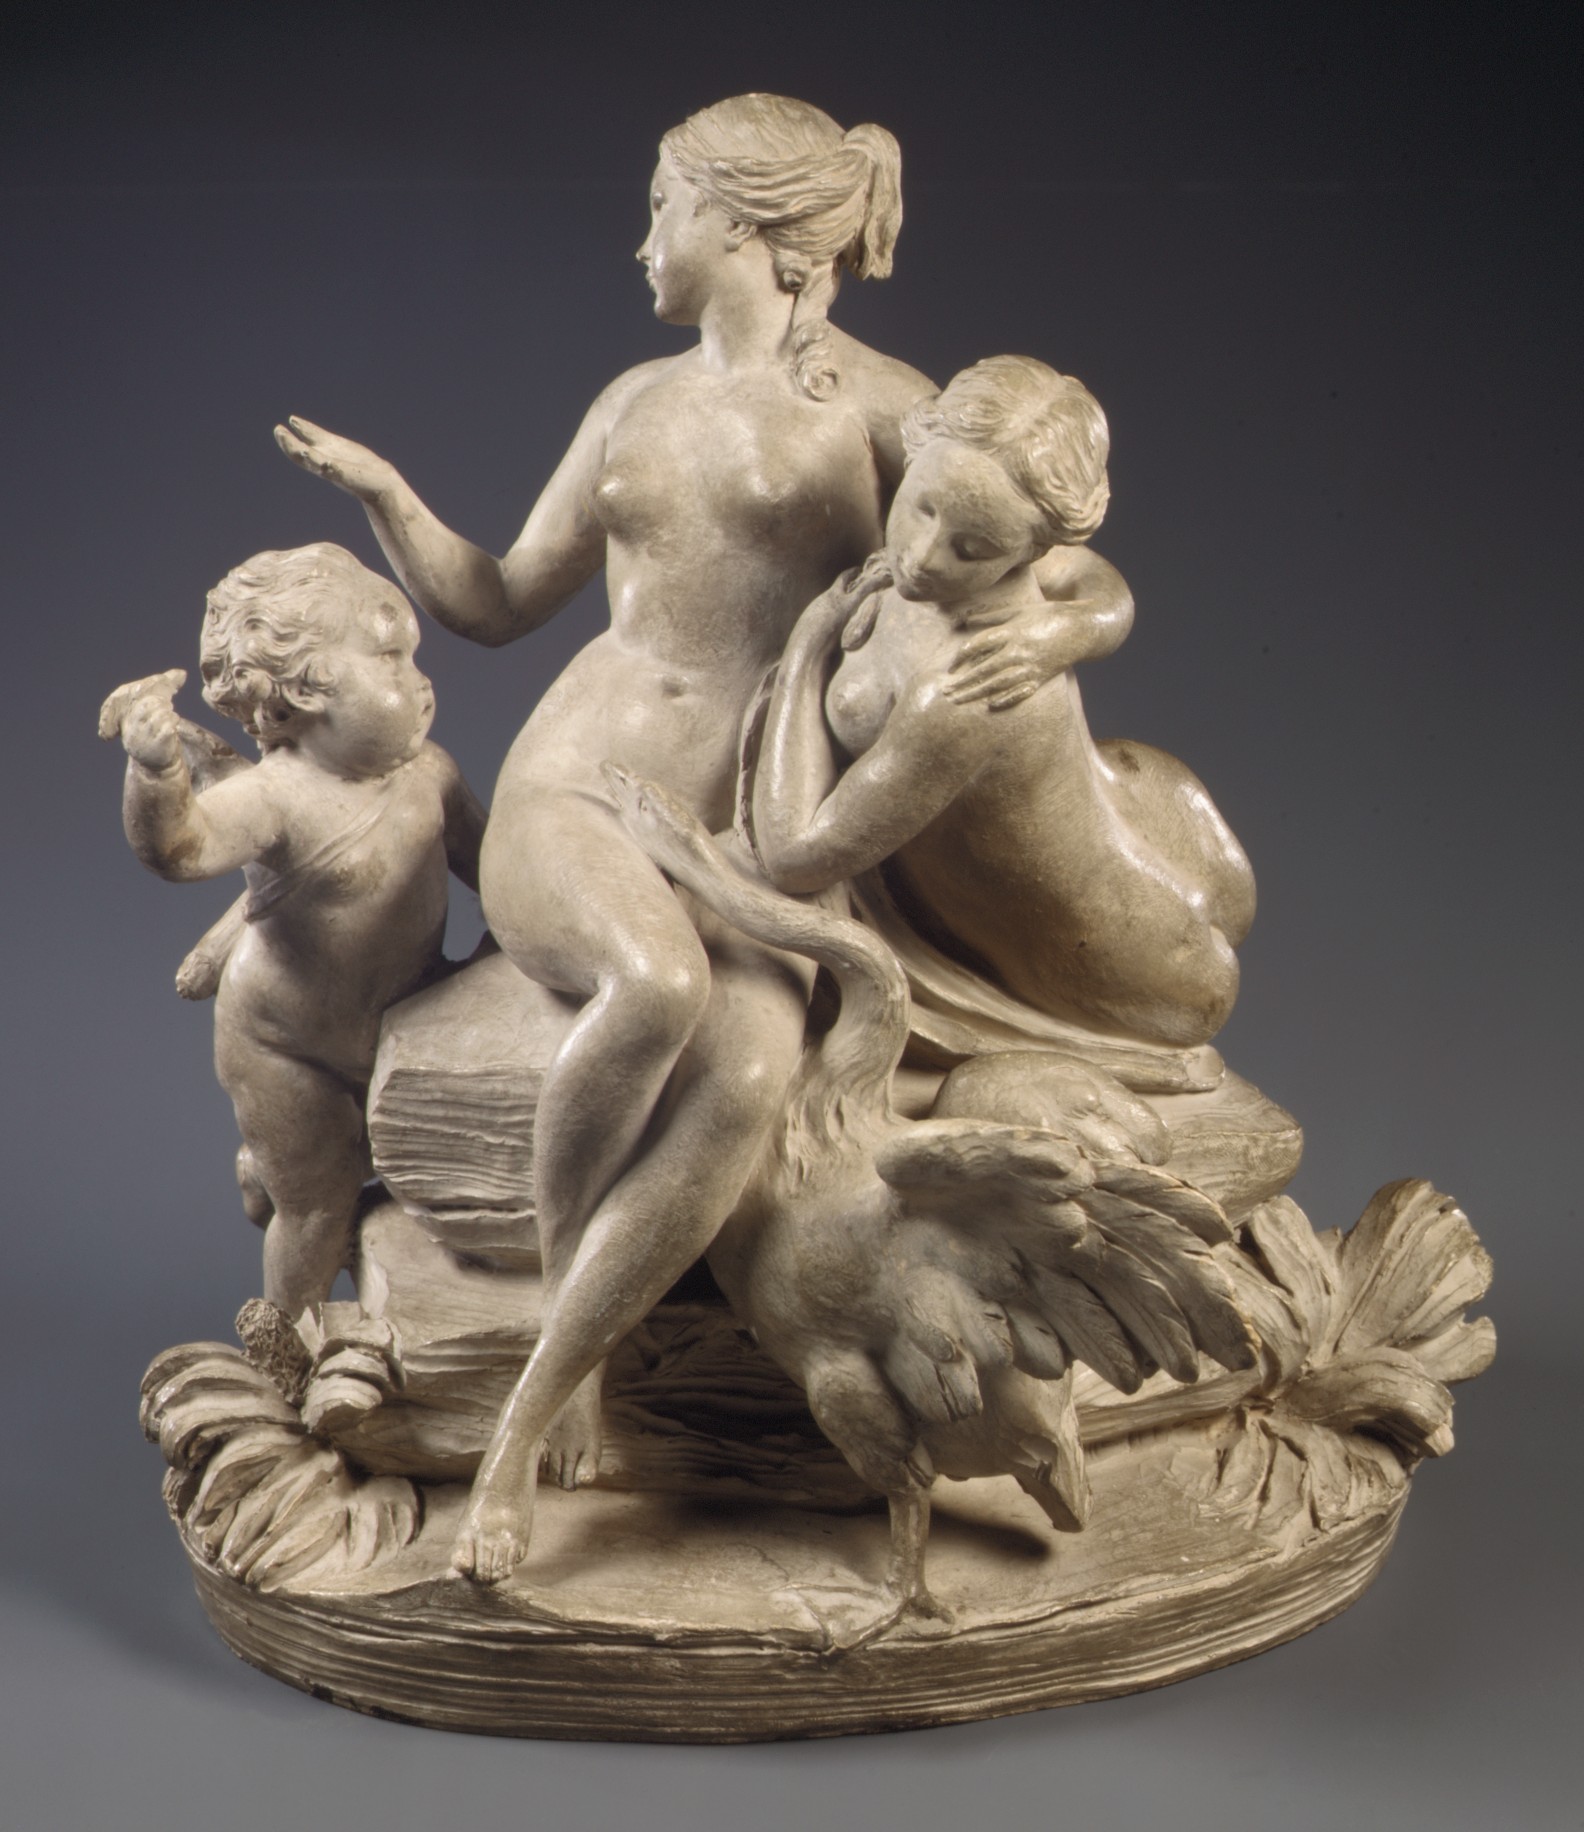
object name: statuette group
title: Leda and the Swan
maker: etienne-maurice falconet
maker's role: artist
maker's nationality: french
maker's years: 1716-1791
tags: female nudes,cupid,leda,swans